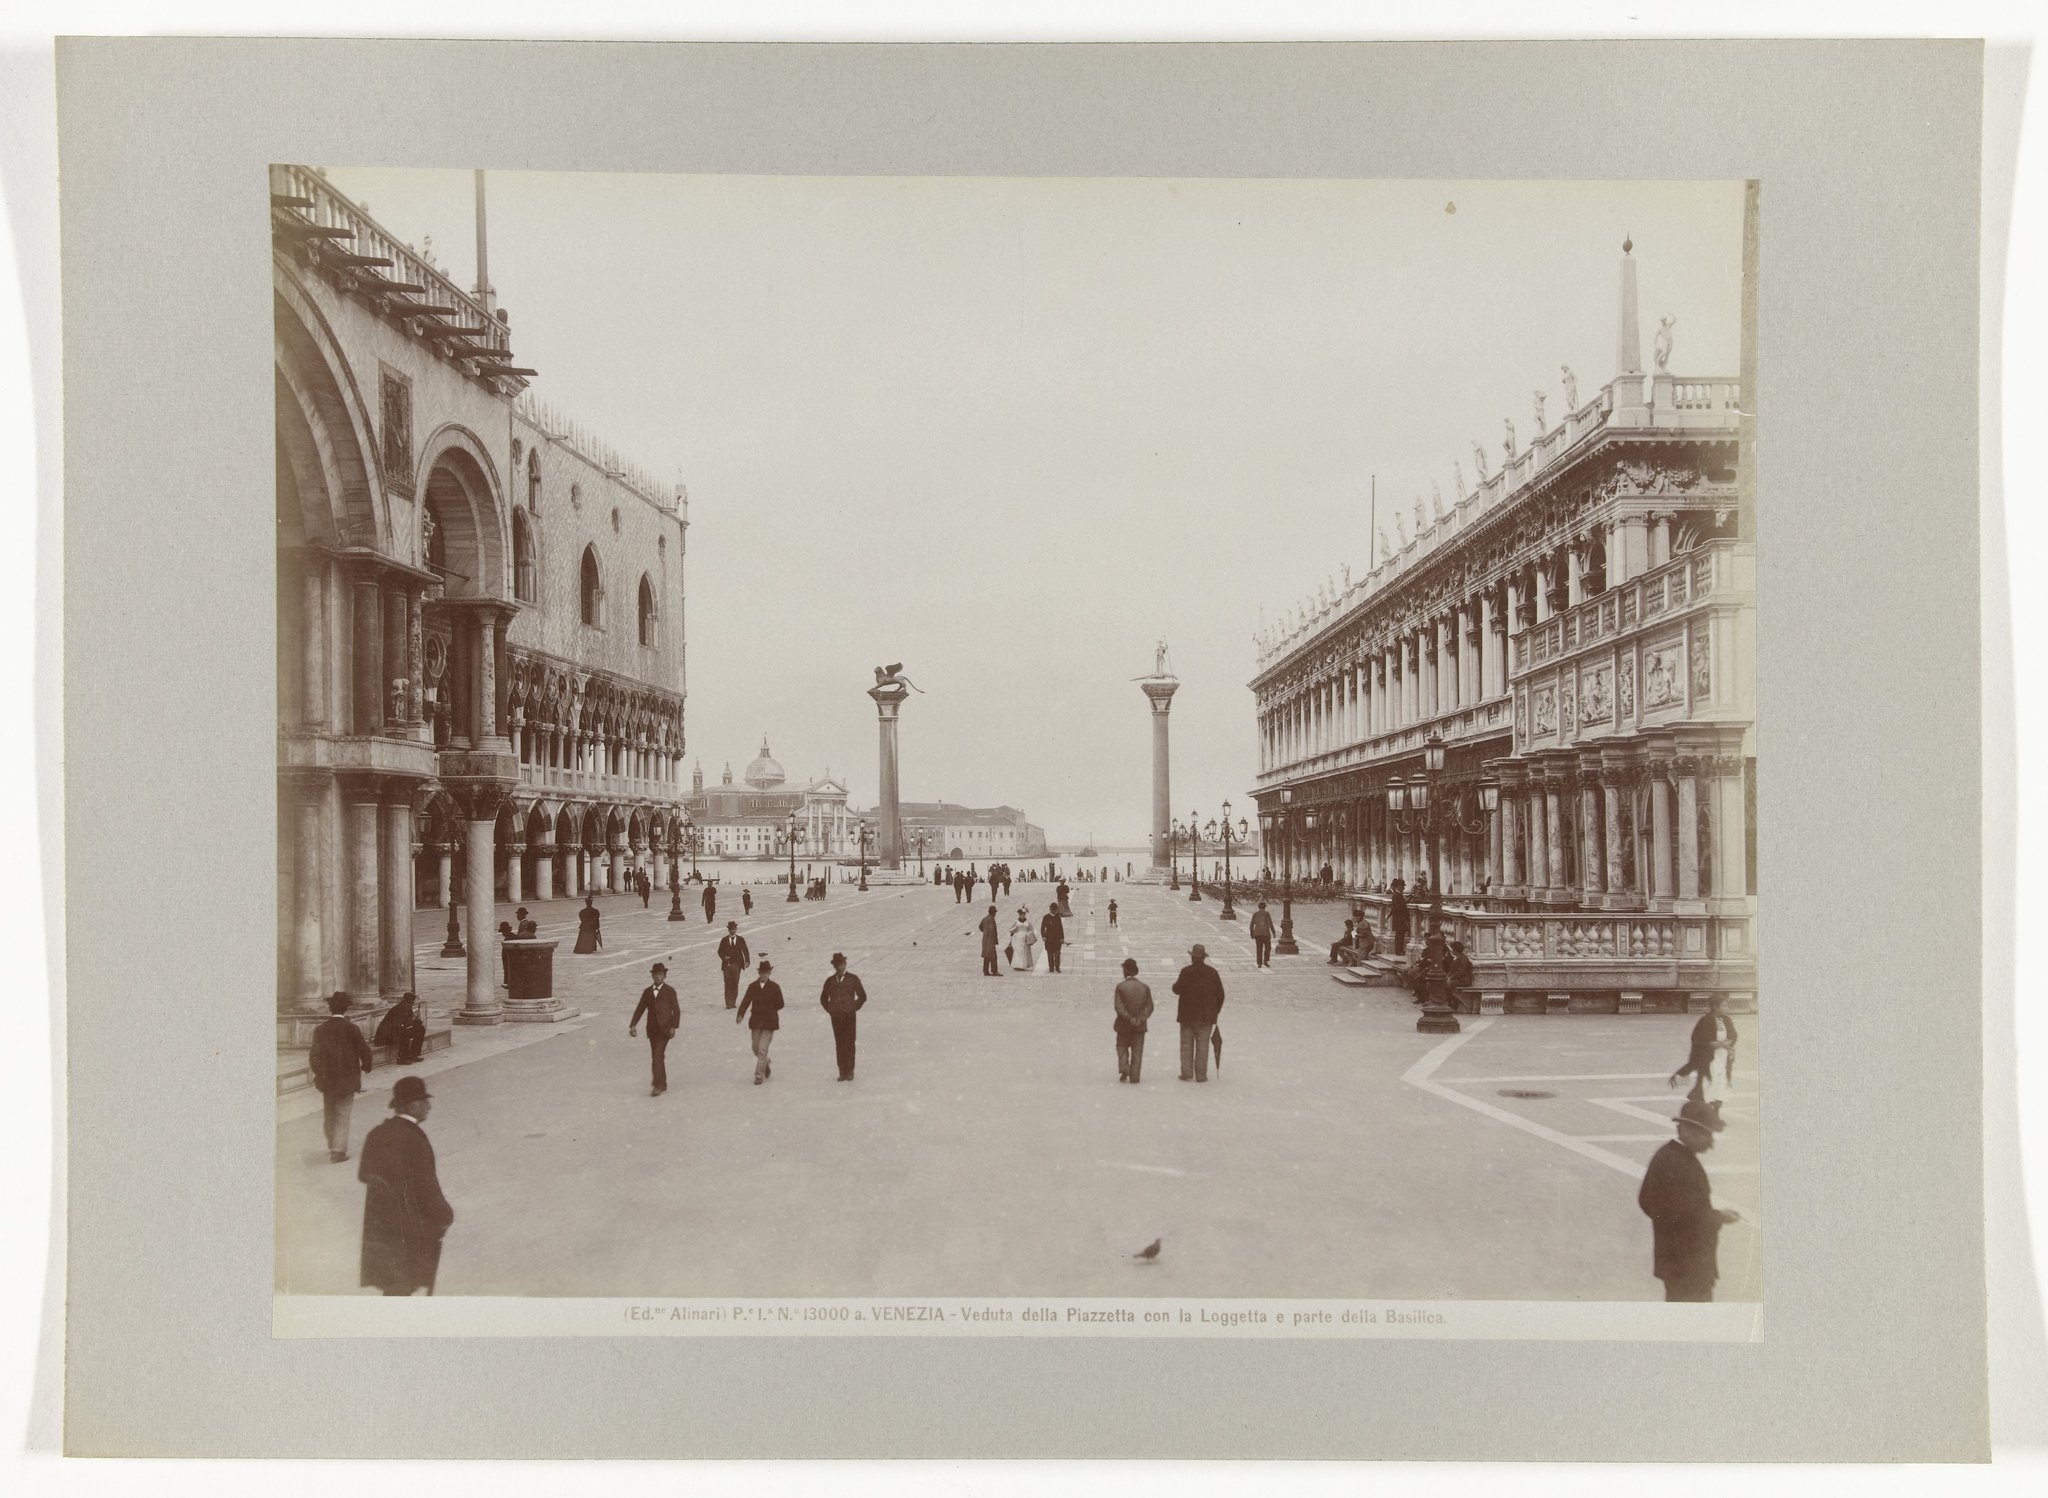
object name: photograph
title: Piazzetta, San Marco, Palazzo Ducale (Dogenpaleis) en Loggetta, Venetië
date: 1880-1895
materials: cardboard, paper, photographic support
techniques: albumen print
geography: florence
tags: square, place, circus, etc., palace, church (exterior), venice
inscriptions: number: ‘104.’